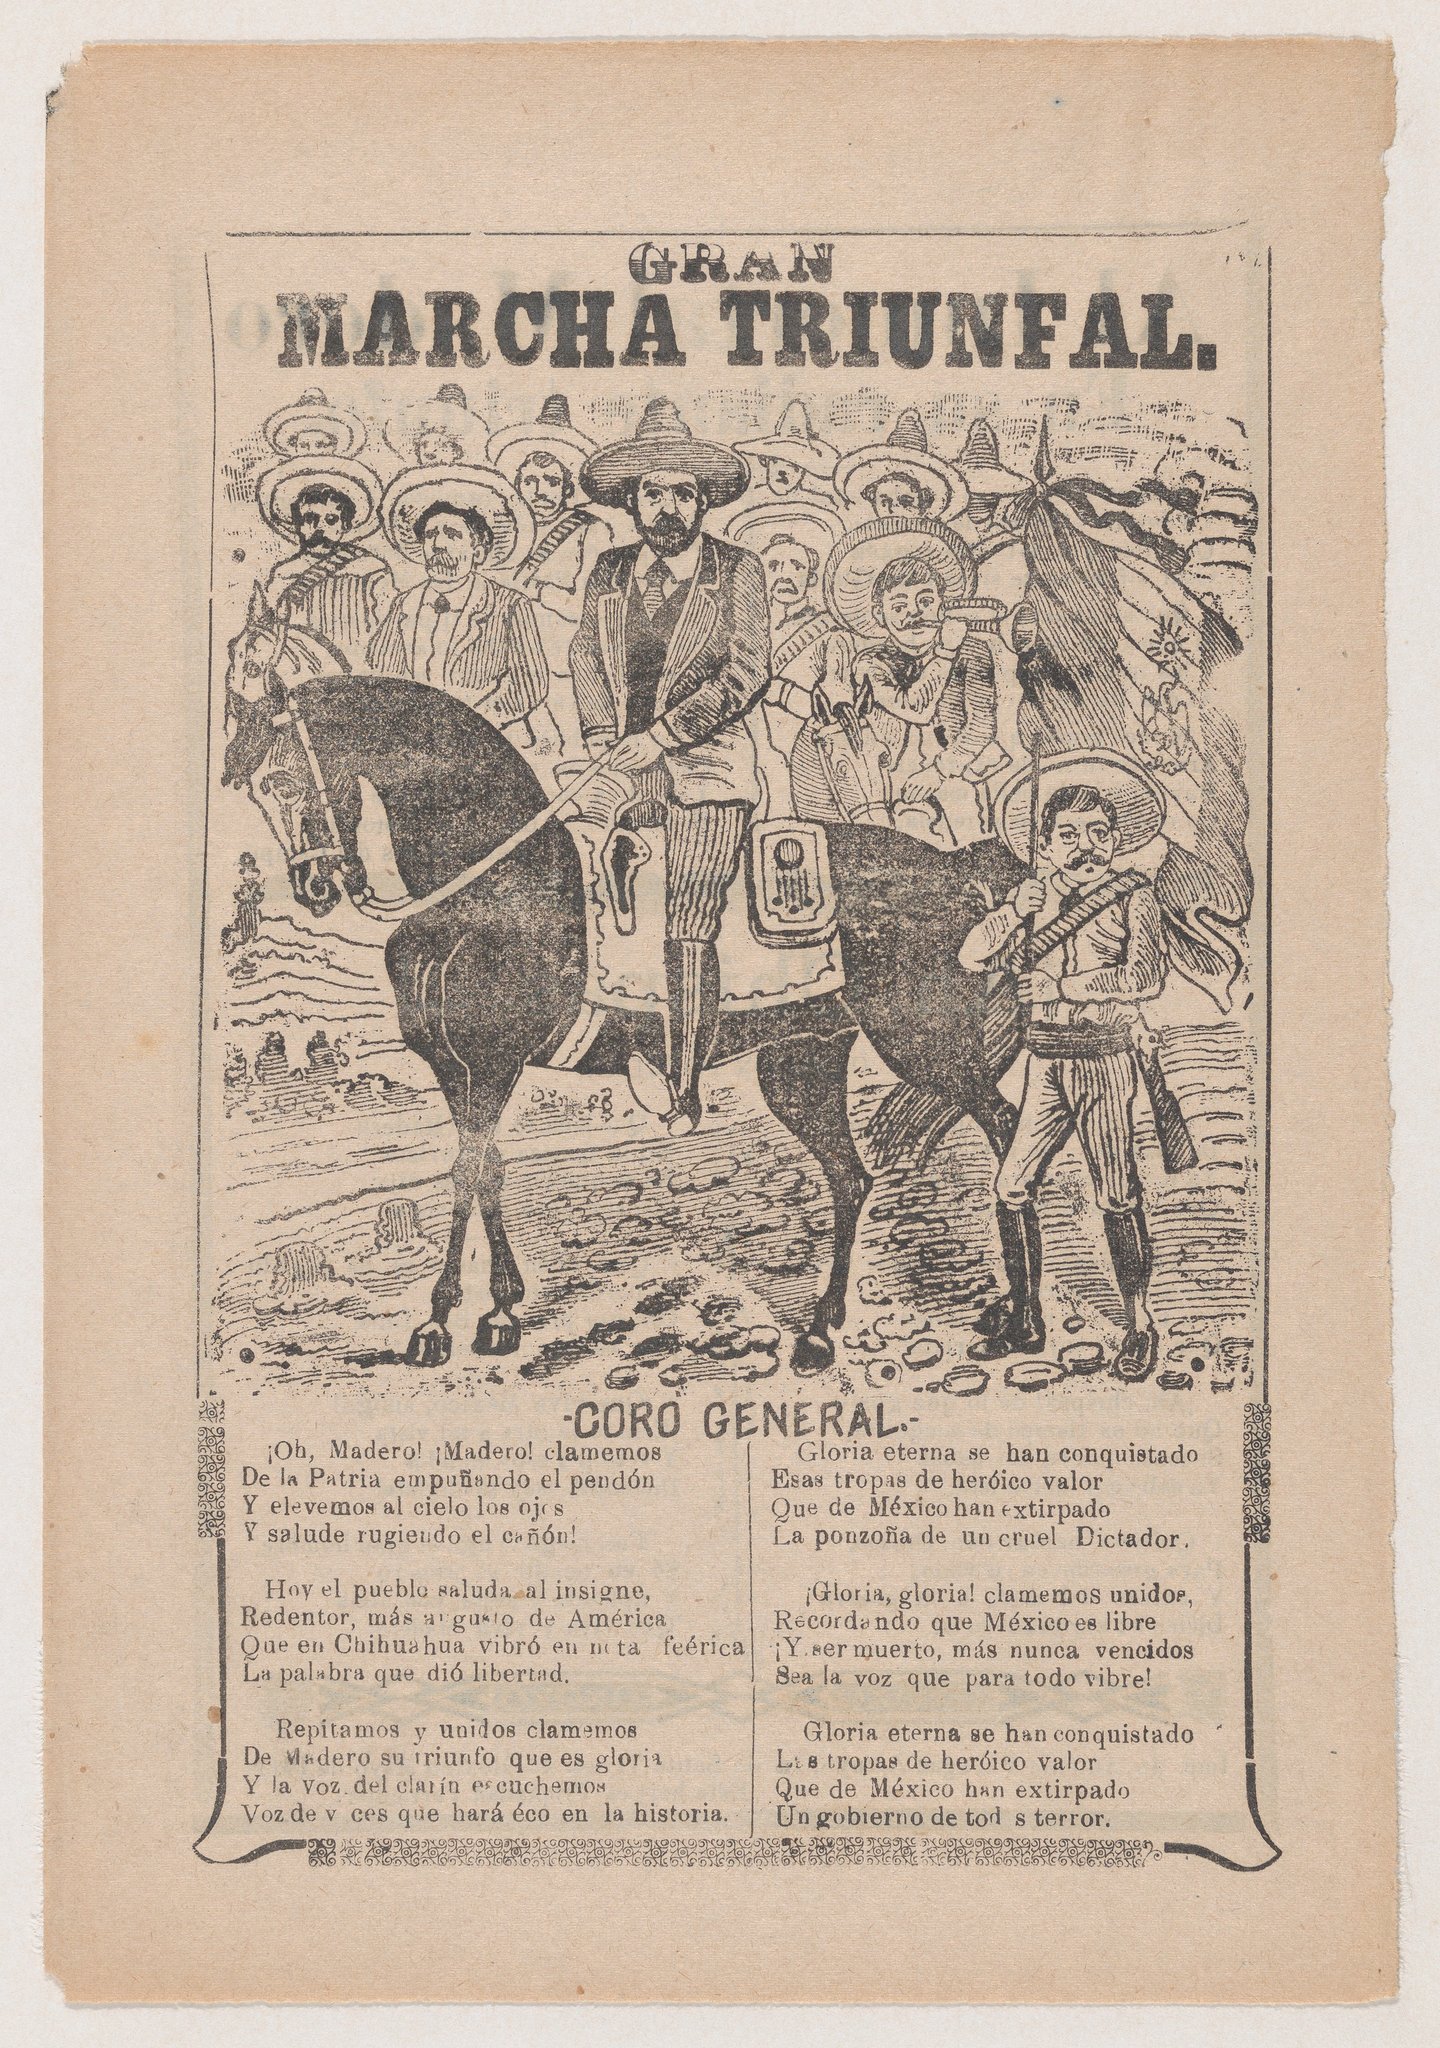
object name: print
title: Broadsheet relating to the triumphal march of Francisco Madero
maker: josé guadalupe posada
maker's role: artist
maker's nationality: mexican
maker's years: 1852-1913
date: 1911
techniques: letterpress, lithography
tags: men,horses